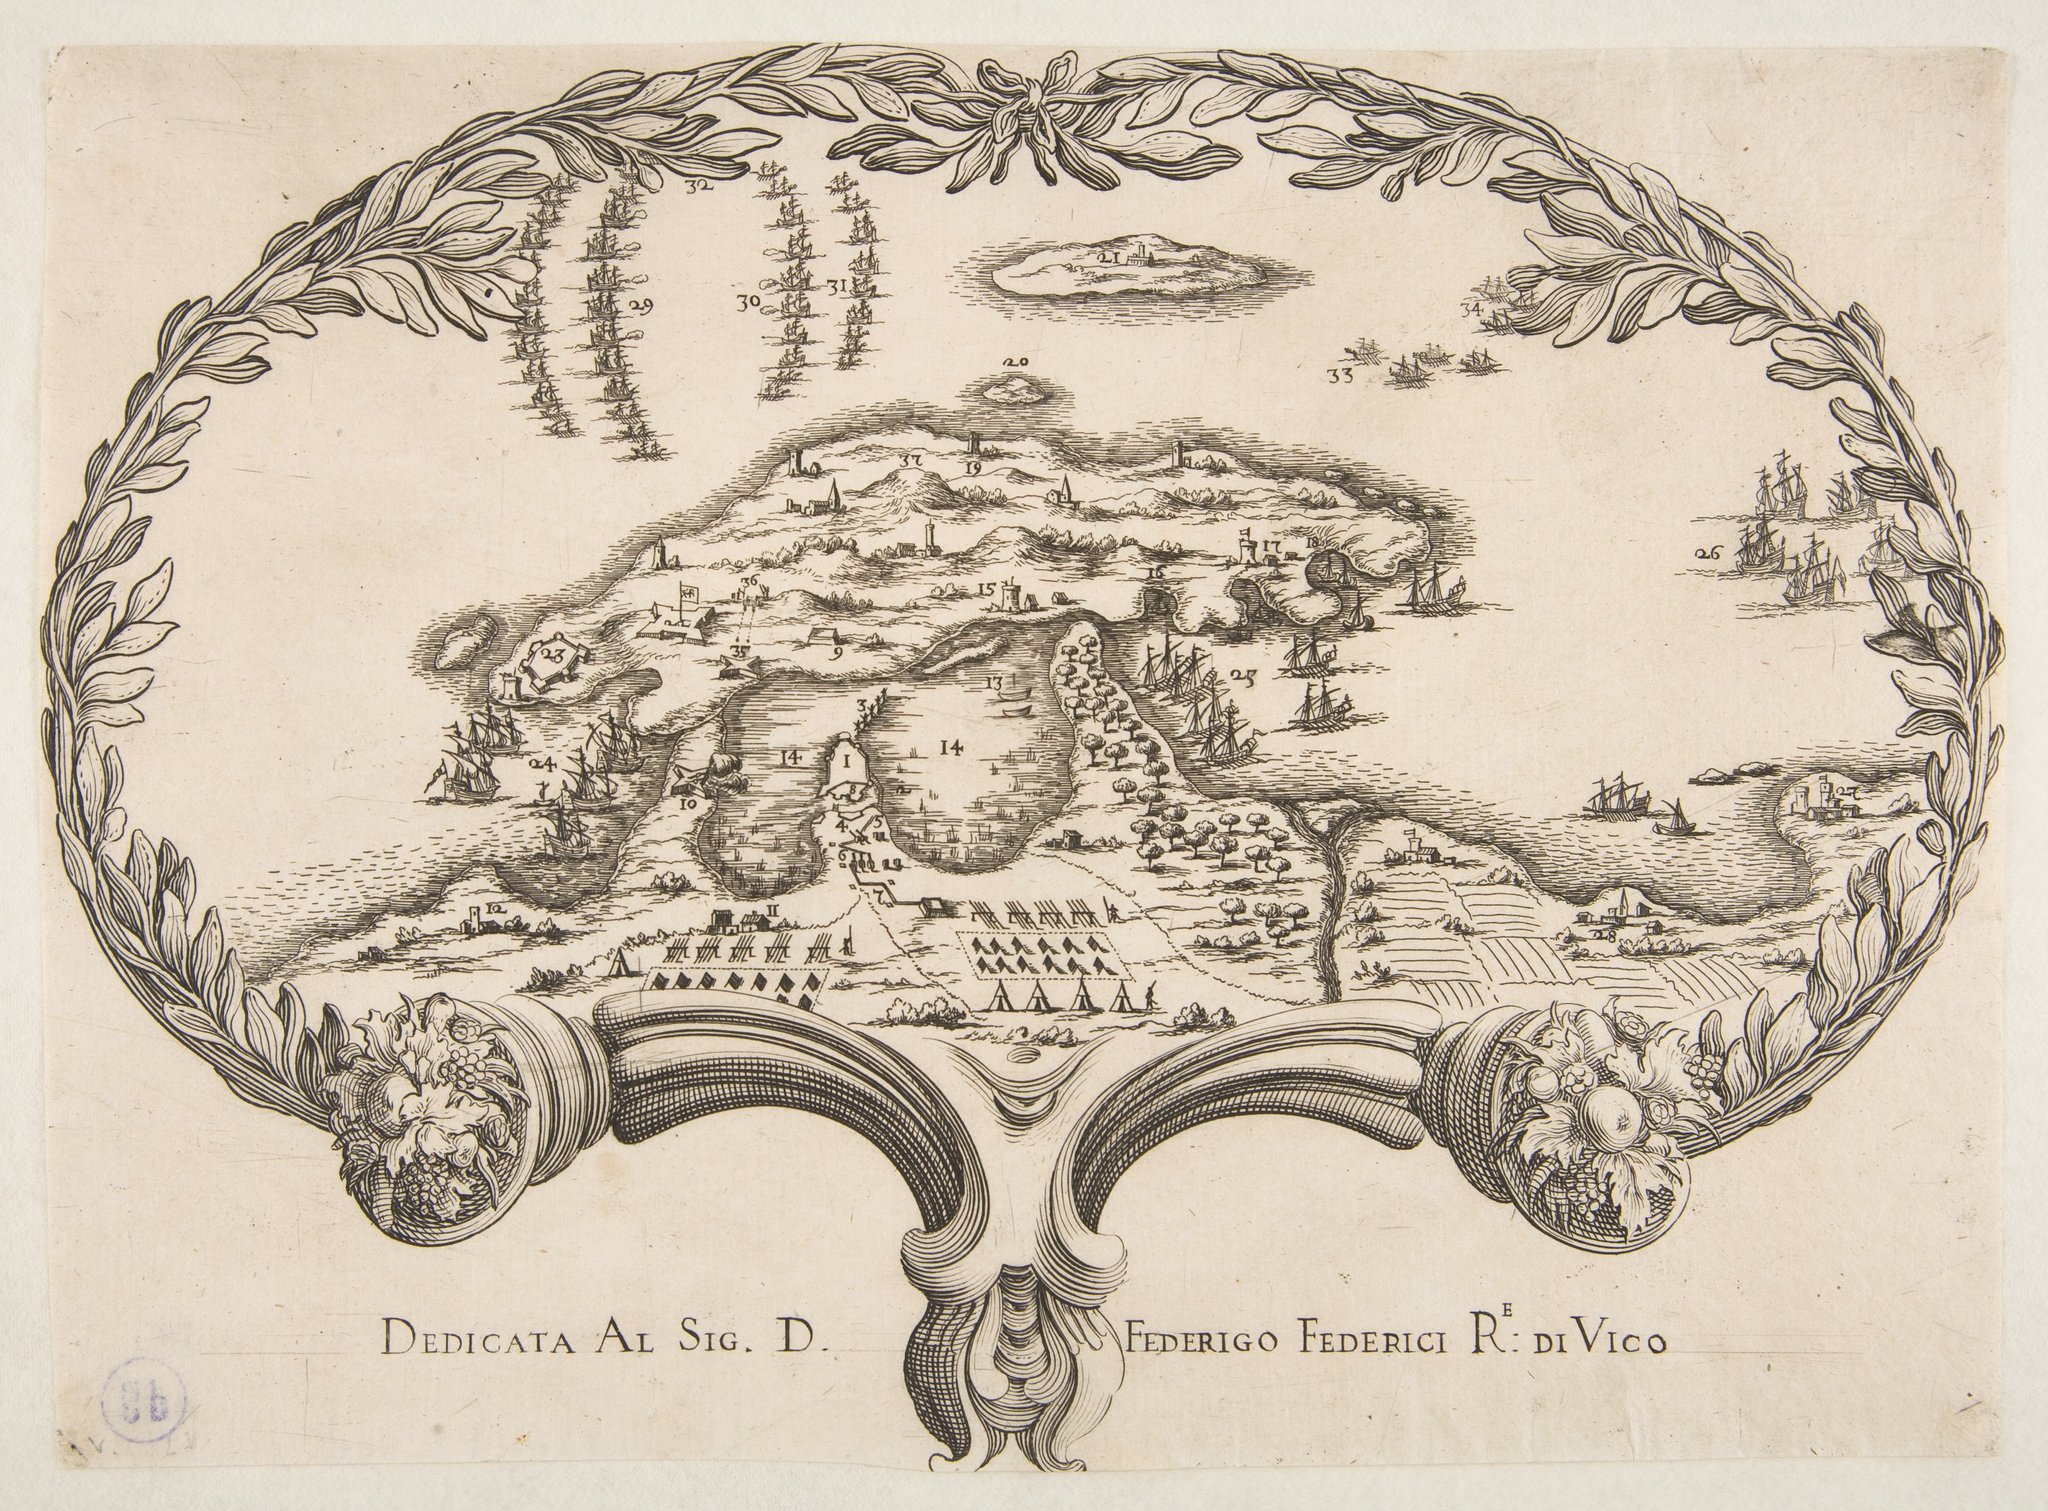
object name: print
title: Topographic Plan (Porto Ercole?) in the Shape of a Fan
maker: anonymous, 17th century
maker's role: printmaker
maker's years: 1600-1700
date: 1600-1700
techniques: engraving, etching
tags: maps